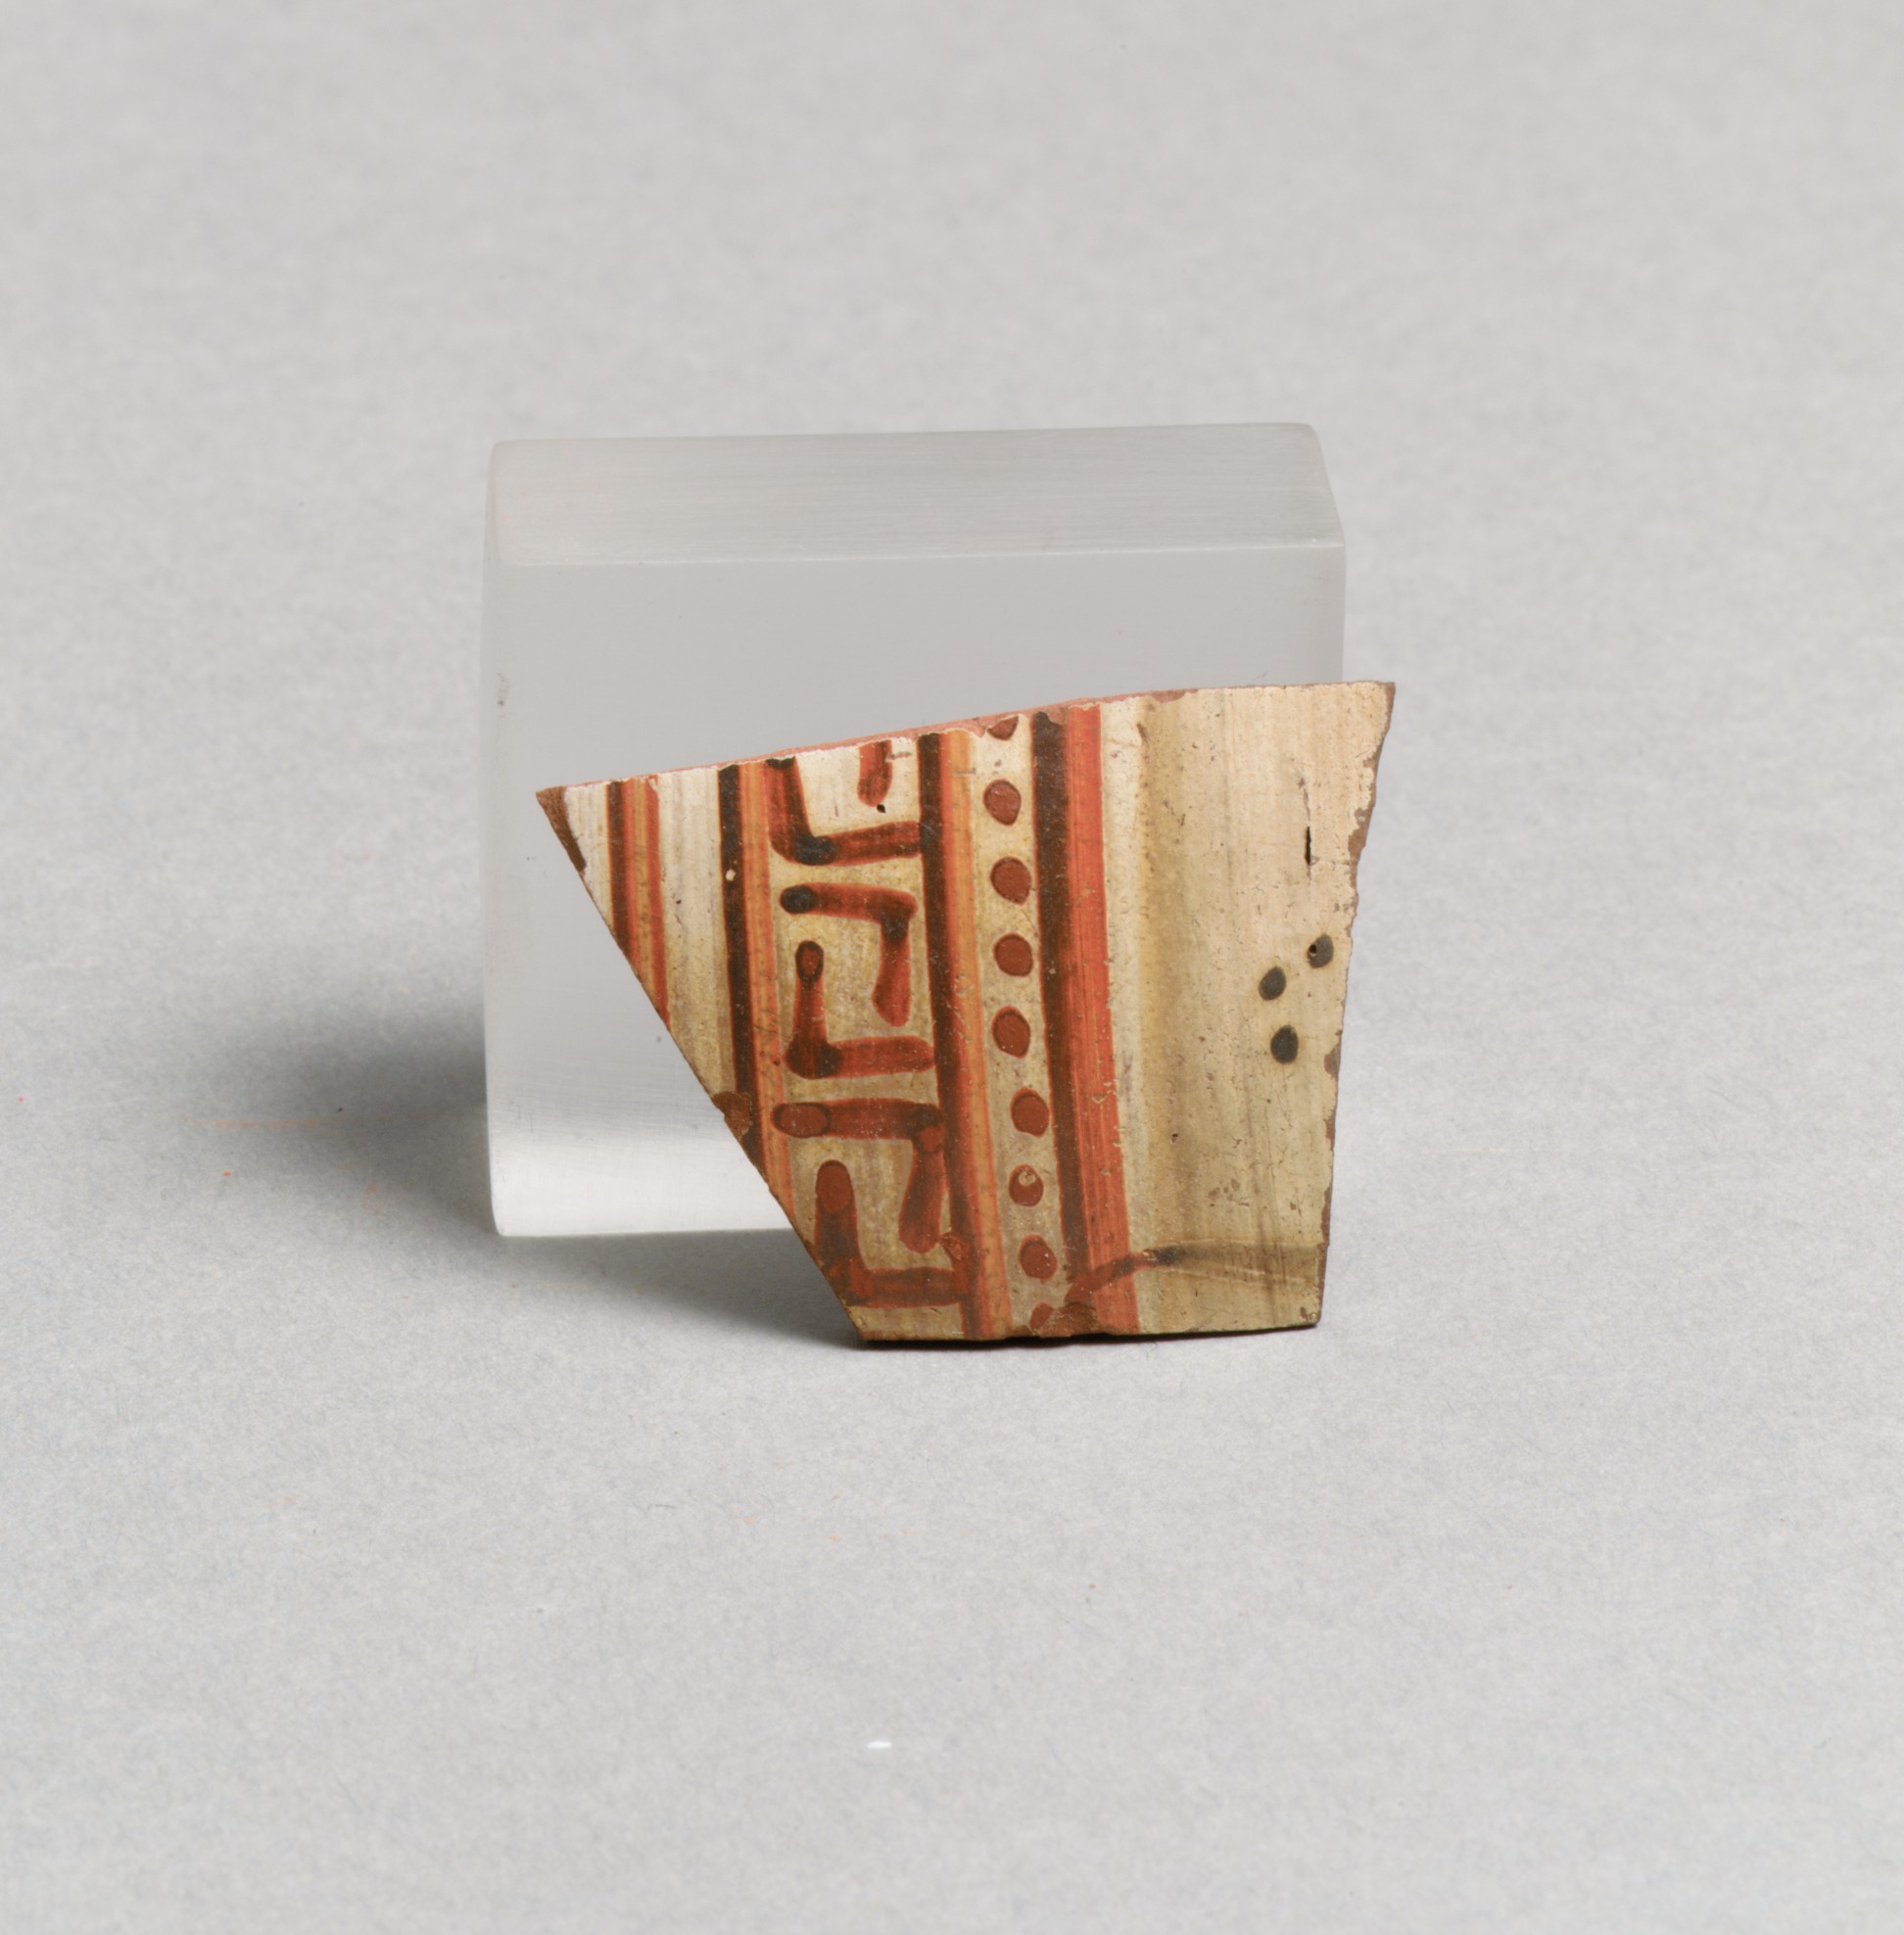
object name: skyphos fragment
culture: greek or lydian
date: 900-30 BCE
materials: terracotta